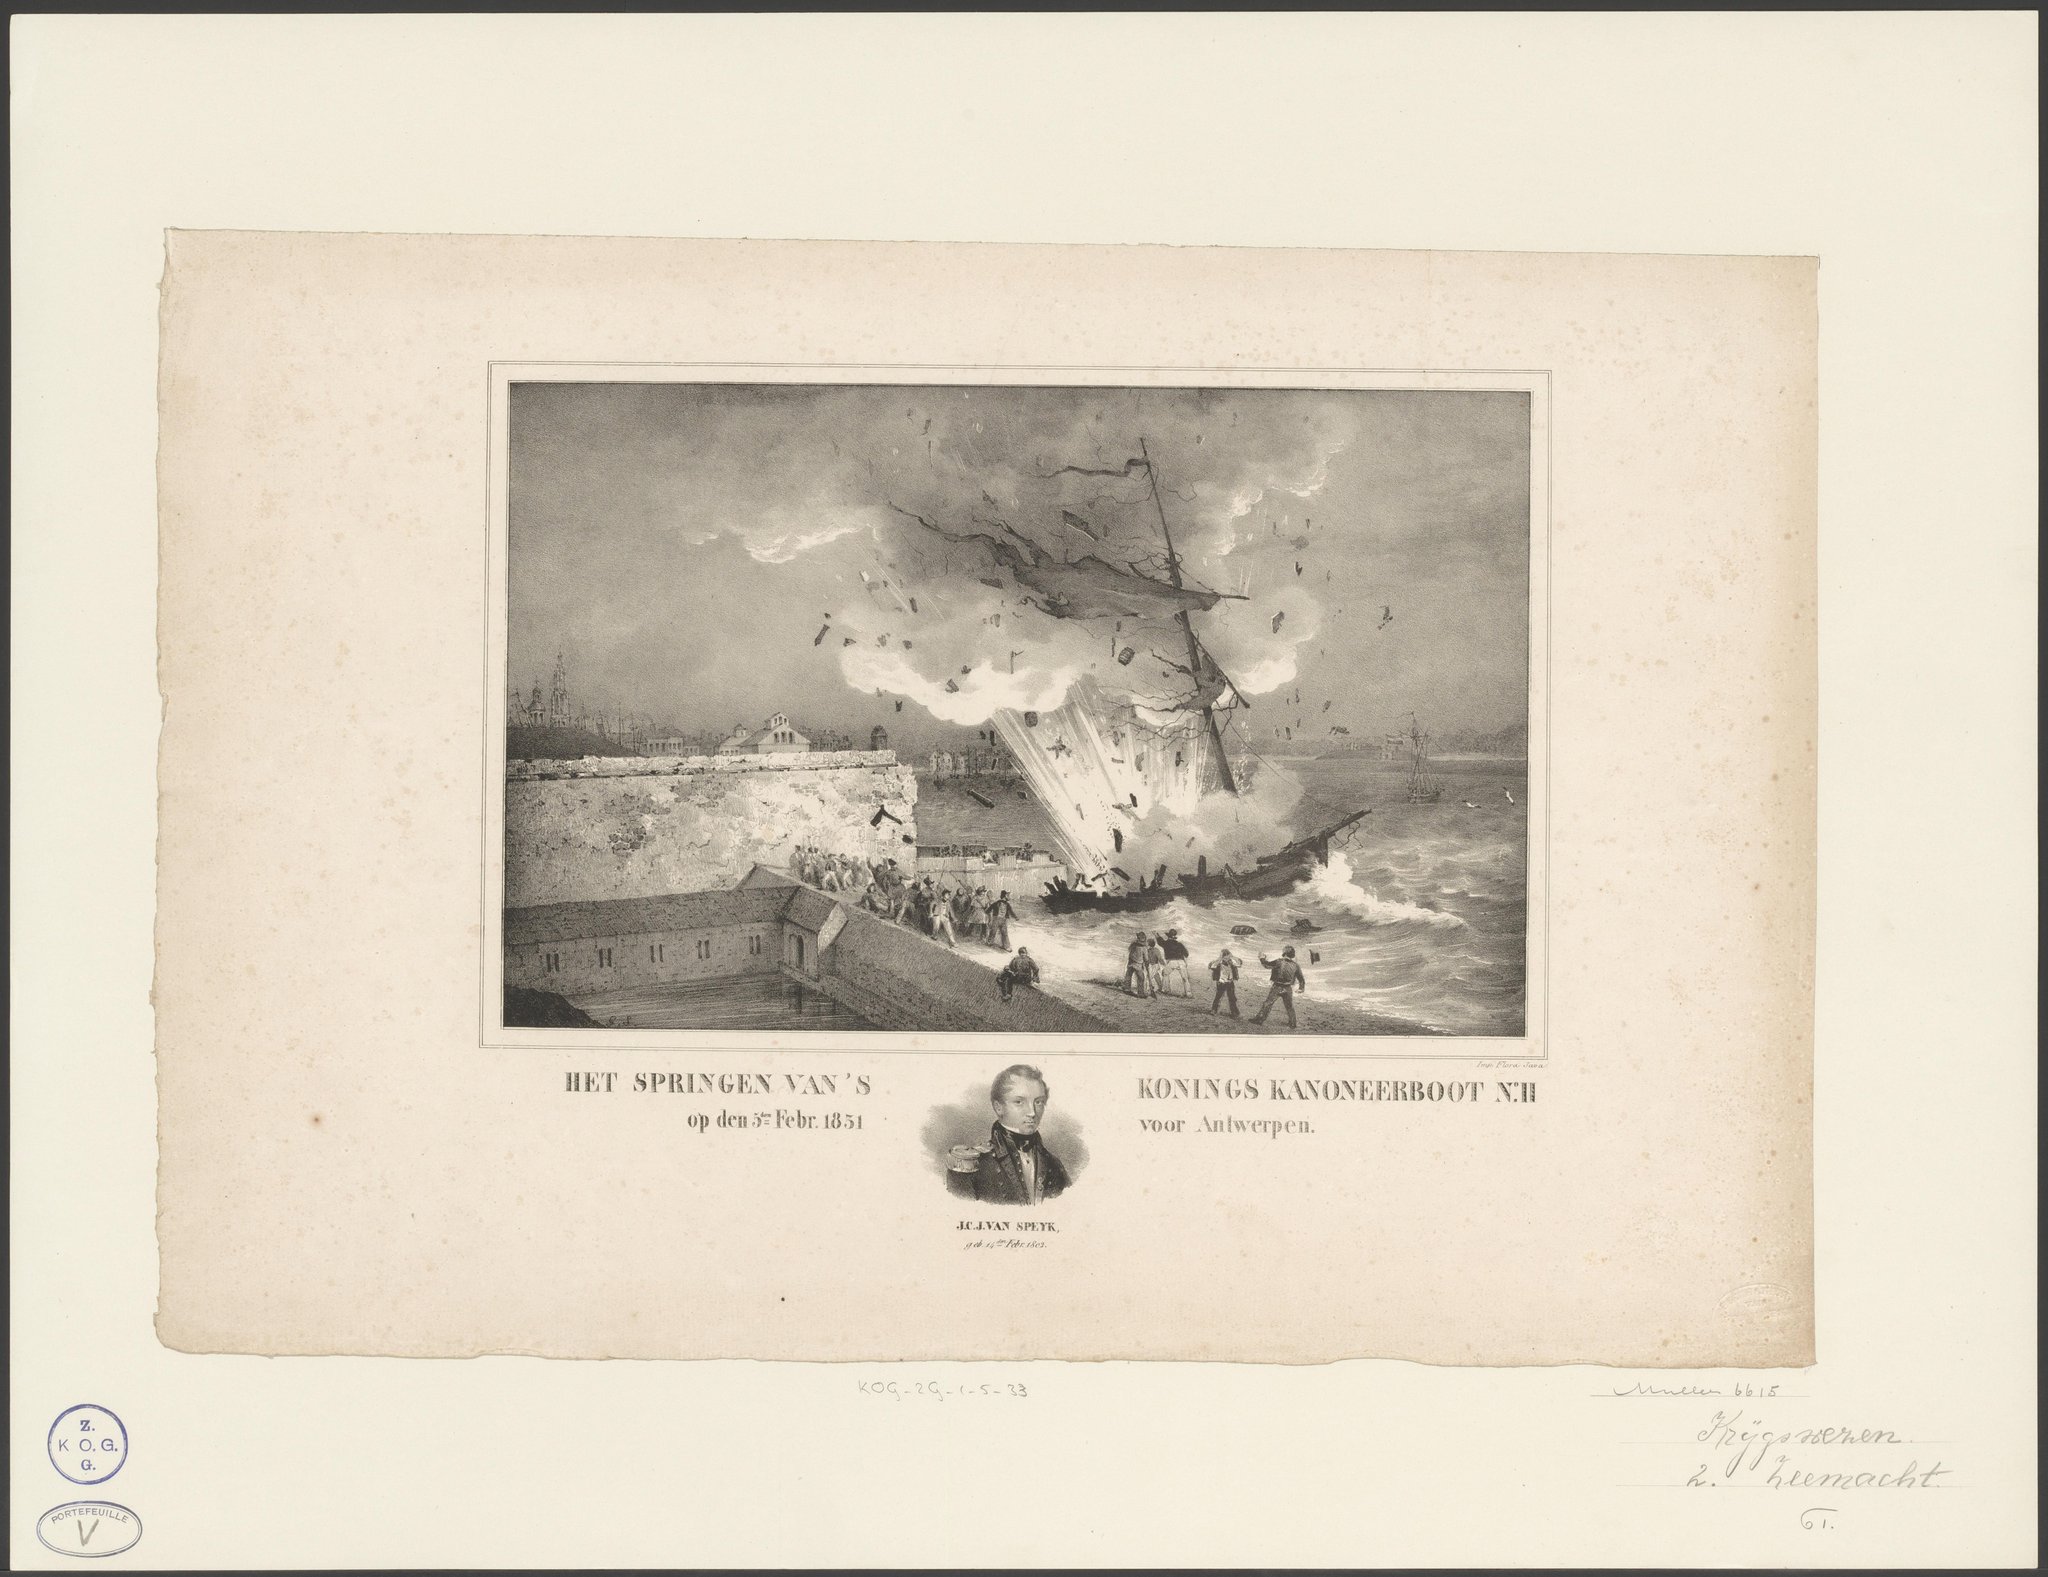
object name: print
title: Ontploffing van kanonneerschip 2 onder leiding van Jan Carel Josephus van Speyk voor Antwerpen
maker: monogrammist gs (lithograaf)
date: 1831-1849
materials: paper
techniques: lithograph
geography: amsterdam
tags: amsterdam, antwerp, jan van speyk, historical persons, ships (in general), battle, fighting in general (+ naval force), being attacked; defence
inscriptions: stamp, collector's mark: Lugt 1641, check stamp: ‘Boekhandel van Gebr. Thedericks (...)’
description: Gezicht op de Schelde met het in de lucht springen van de kanonneerboot van Jan Carel Josephus van Speyk, 5 februari 1831. Op de voorgrond publiek op de kade. Onderaan een portret van Jan van Speyk. Onderwerpsrubrieken binnen de Atlas Zeden en Gewoonten: Krijgswezen, Zeemacht.